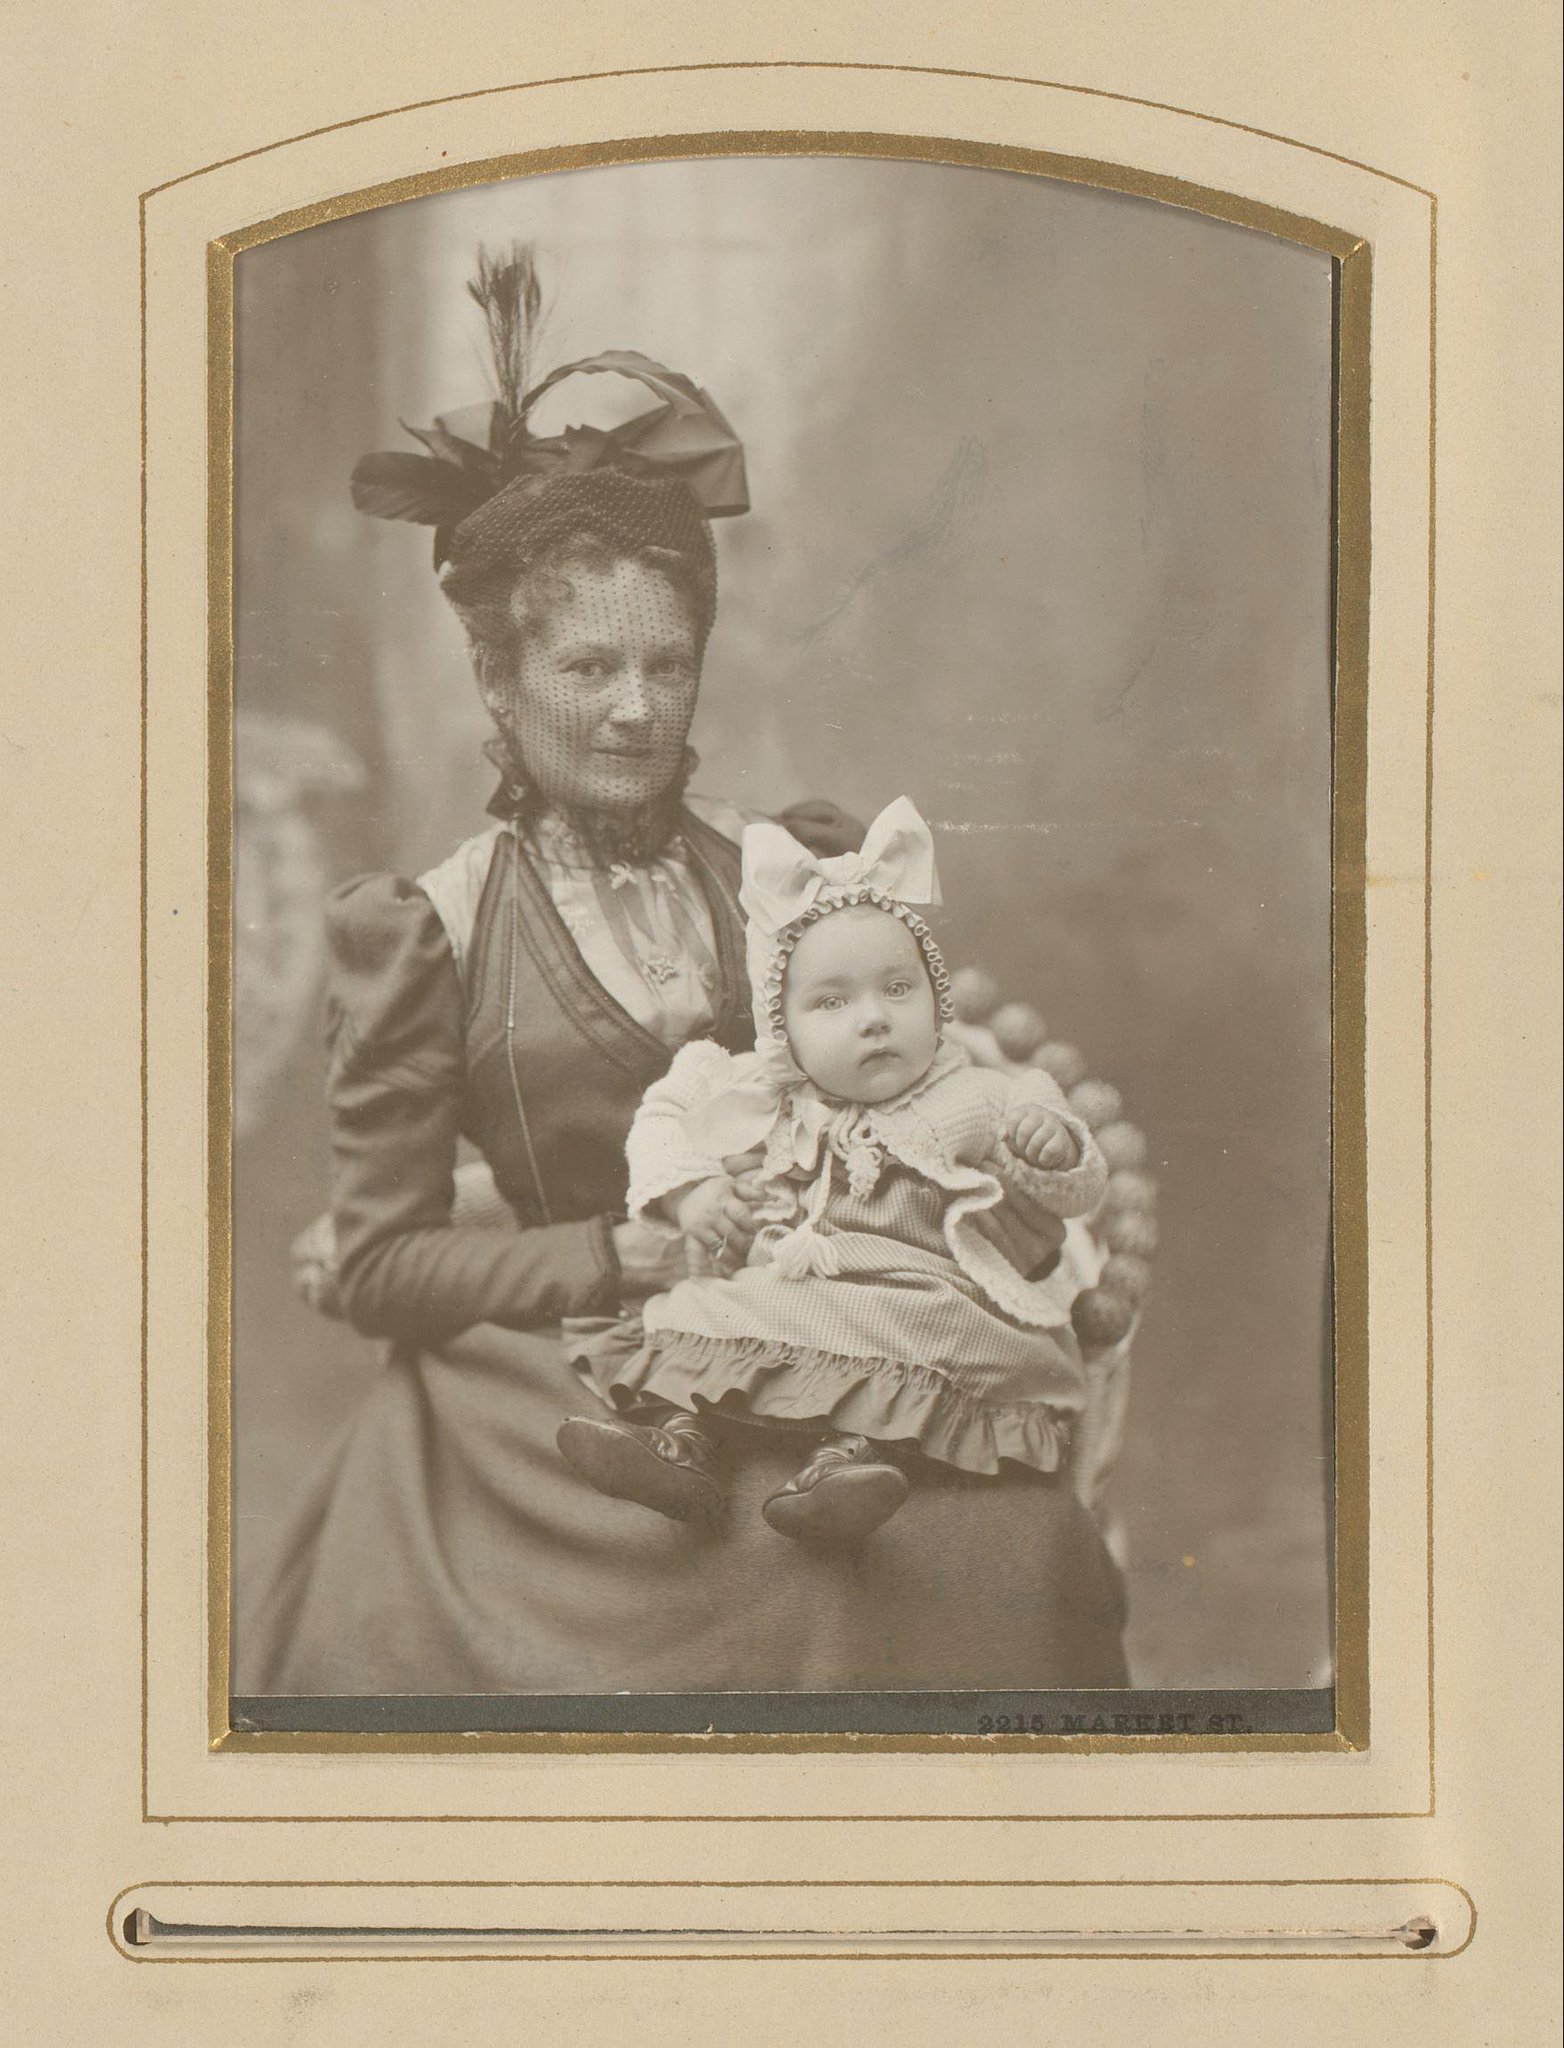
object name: photograph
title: Portret van een vrouw met een baby op schoot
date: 1895-1920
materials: cardboard, photographic support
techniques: matte daylight collodion silver print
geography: galveston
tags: historical persons - bb - woman, infant, baby ~ the ages of man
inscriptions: dedication: ‘Den lieben [...]/ [...]/ [...] Hedwig.’, inscription: ‘Harper & Co./ 2215 MARKET ST./ CALVESTON, TEXAS/ 507 1-2 MAIN ST./ HOUSTON, TEXAS/ ENNIS, TEXAS’